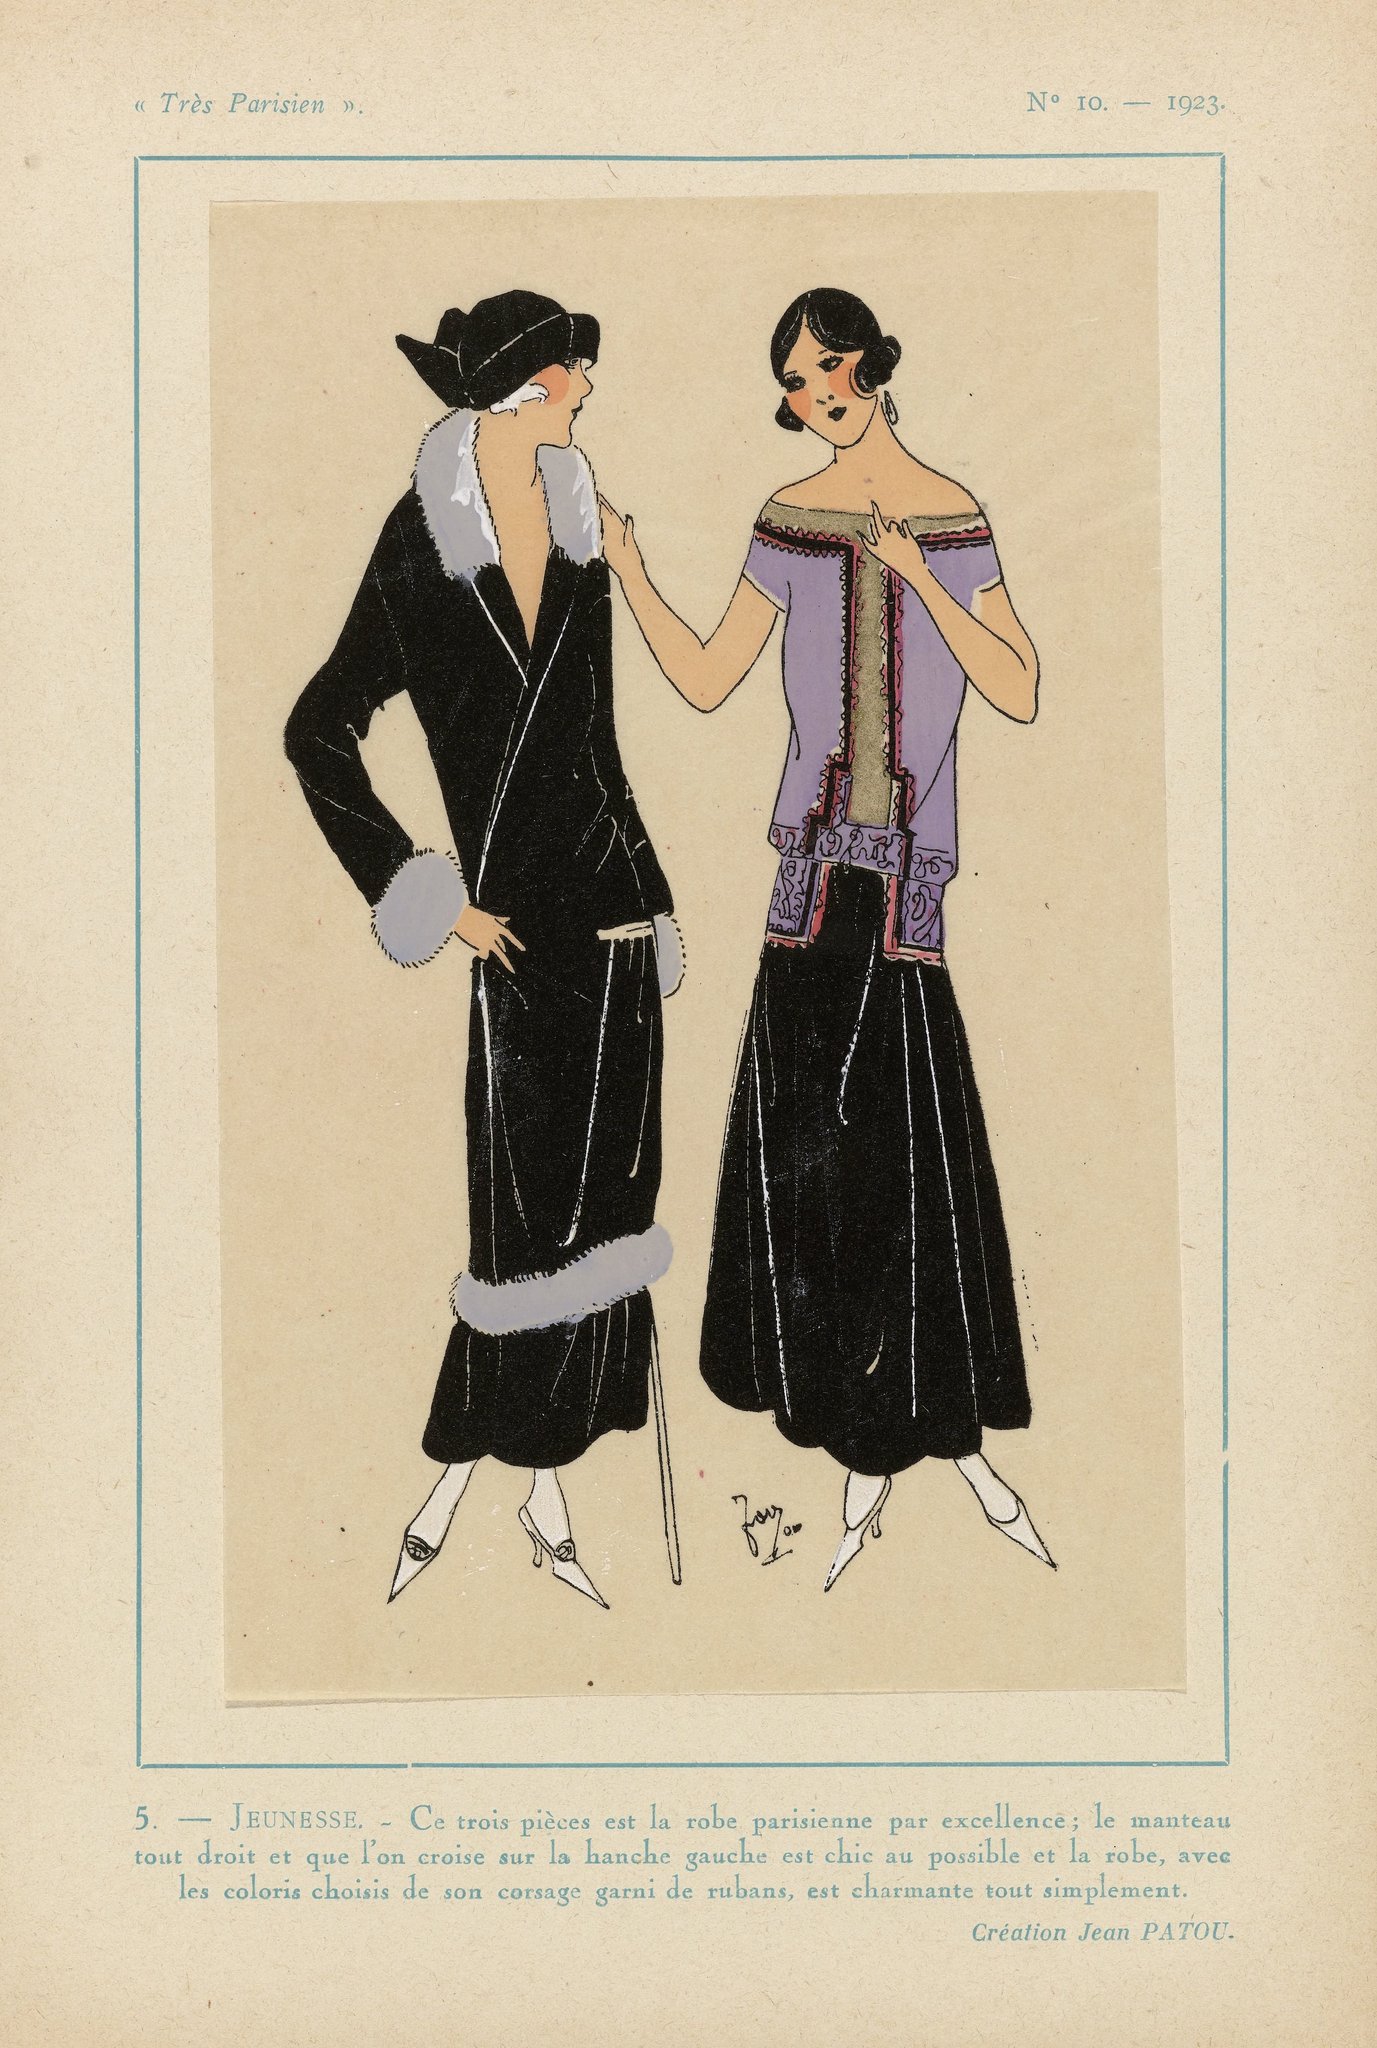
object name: fashion print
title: Très Parisien, 1923, No 10: 5.- JEUNESSE. - Ce trois pièces...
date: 1923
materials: paper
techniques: hand coloring, letterpress printing, lithography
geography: paris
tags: border, ribbon, braid (+ women's clothes), ensembles of pieces of clothing (three piece suit) (+ women's clothes), coat (+ women's clothes), fashion plates, head-gear: hat (+ women's clothes), dress, gown (+ women's clothes), neck-gear: collar (+ fur used for clothes)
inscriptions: title: ‘Très Parisien / No 10. - 1923’, caption: ‘5. - JEUNESSE. - Ce trois pièces est la robe parisiennne par excellence; le manteau tout droit et que l'on croise sur la hanche gauche est chic au possible et la robe, avec les coloris choisis de son corsage garni de rubans, est charmante tout simplement. / Création Jean PATOU.’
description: Trois-pièces. 'Robe parisiennne' (jurk), waarvan het lijfje is gegarneerd met linten. Mantel, recht model met sluiting op de linkerheup, gegarneerd met bont. Ontwerpen van Jean Patou. Prent uit het modetijdschrift Très Parisien (1920-1936).